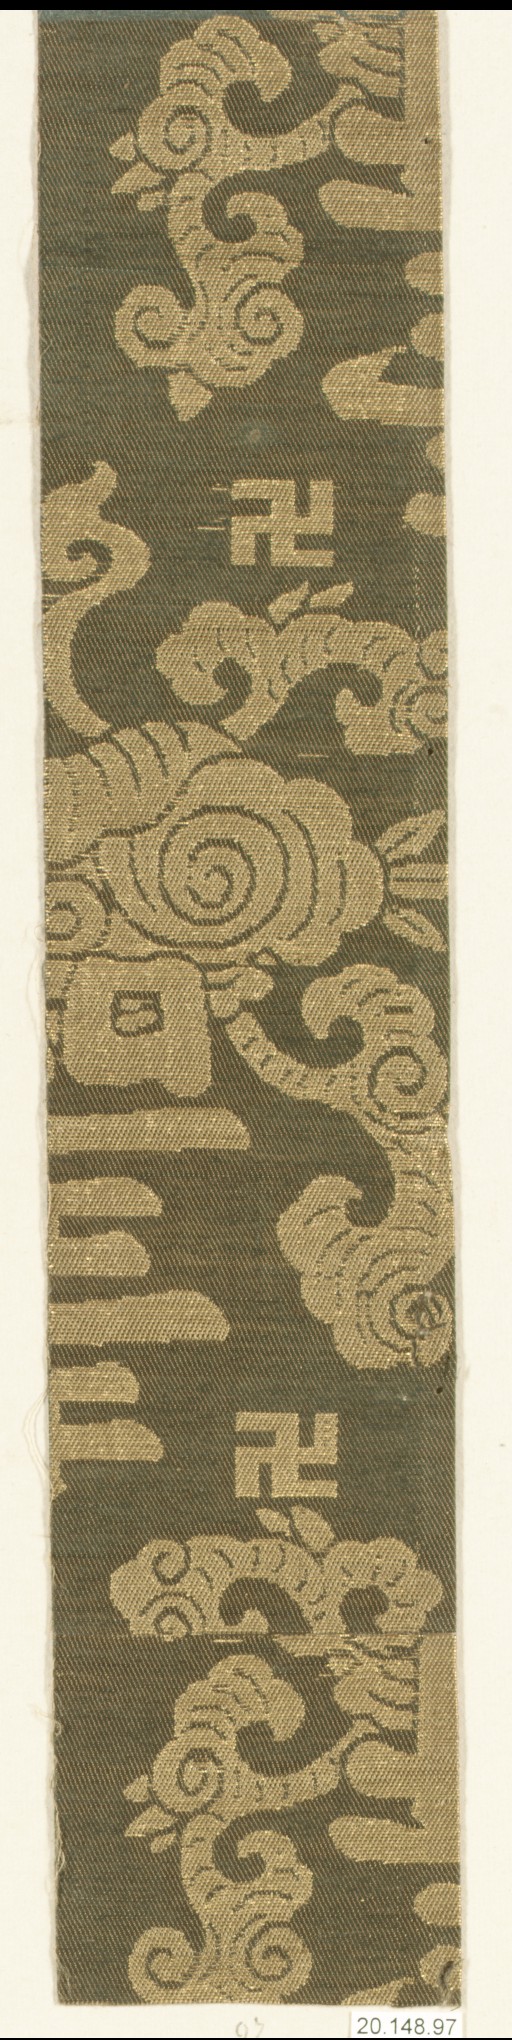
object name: piece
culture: japanese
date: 1701-1800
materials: silk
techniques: compound weave